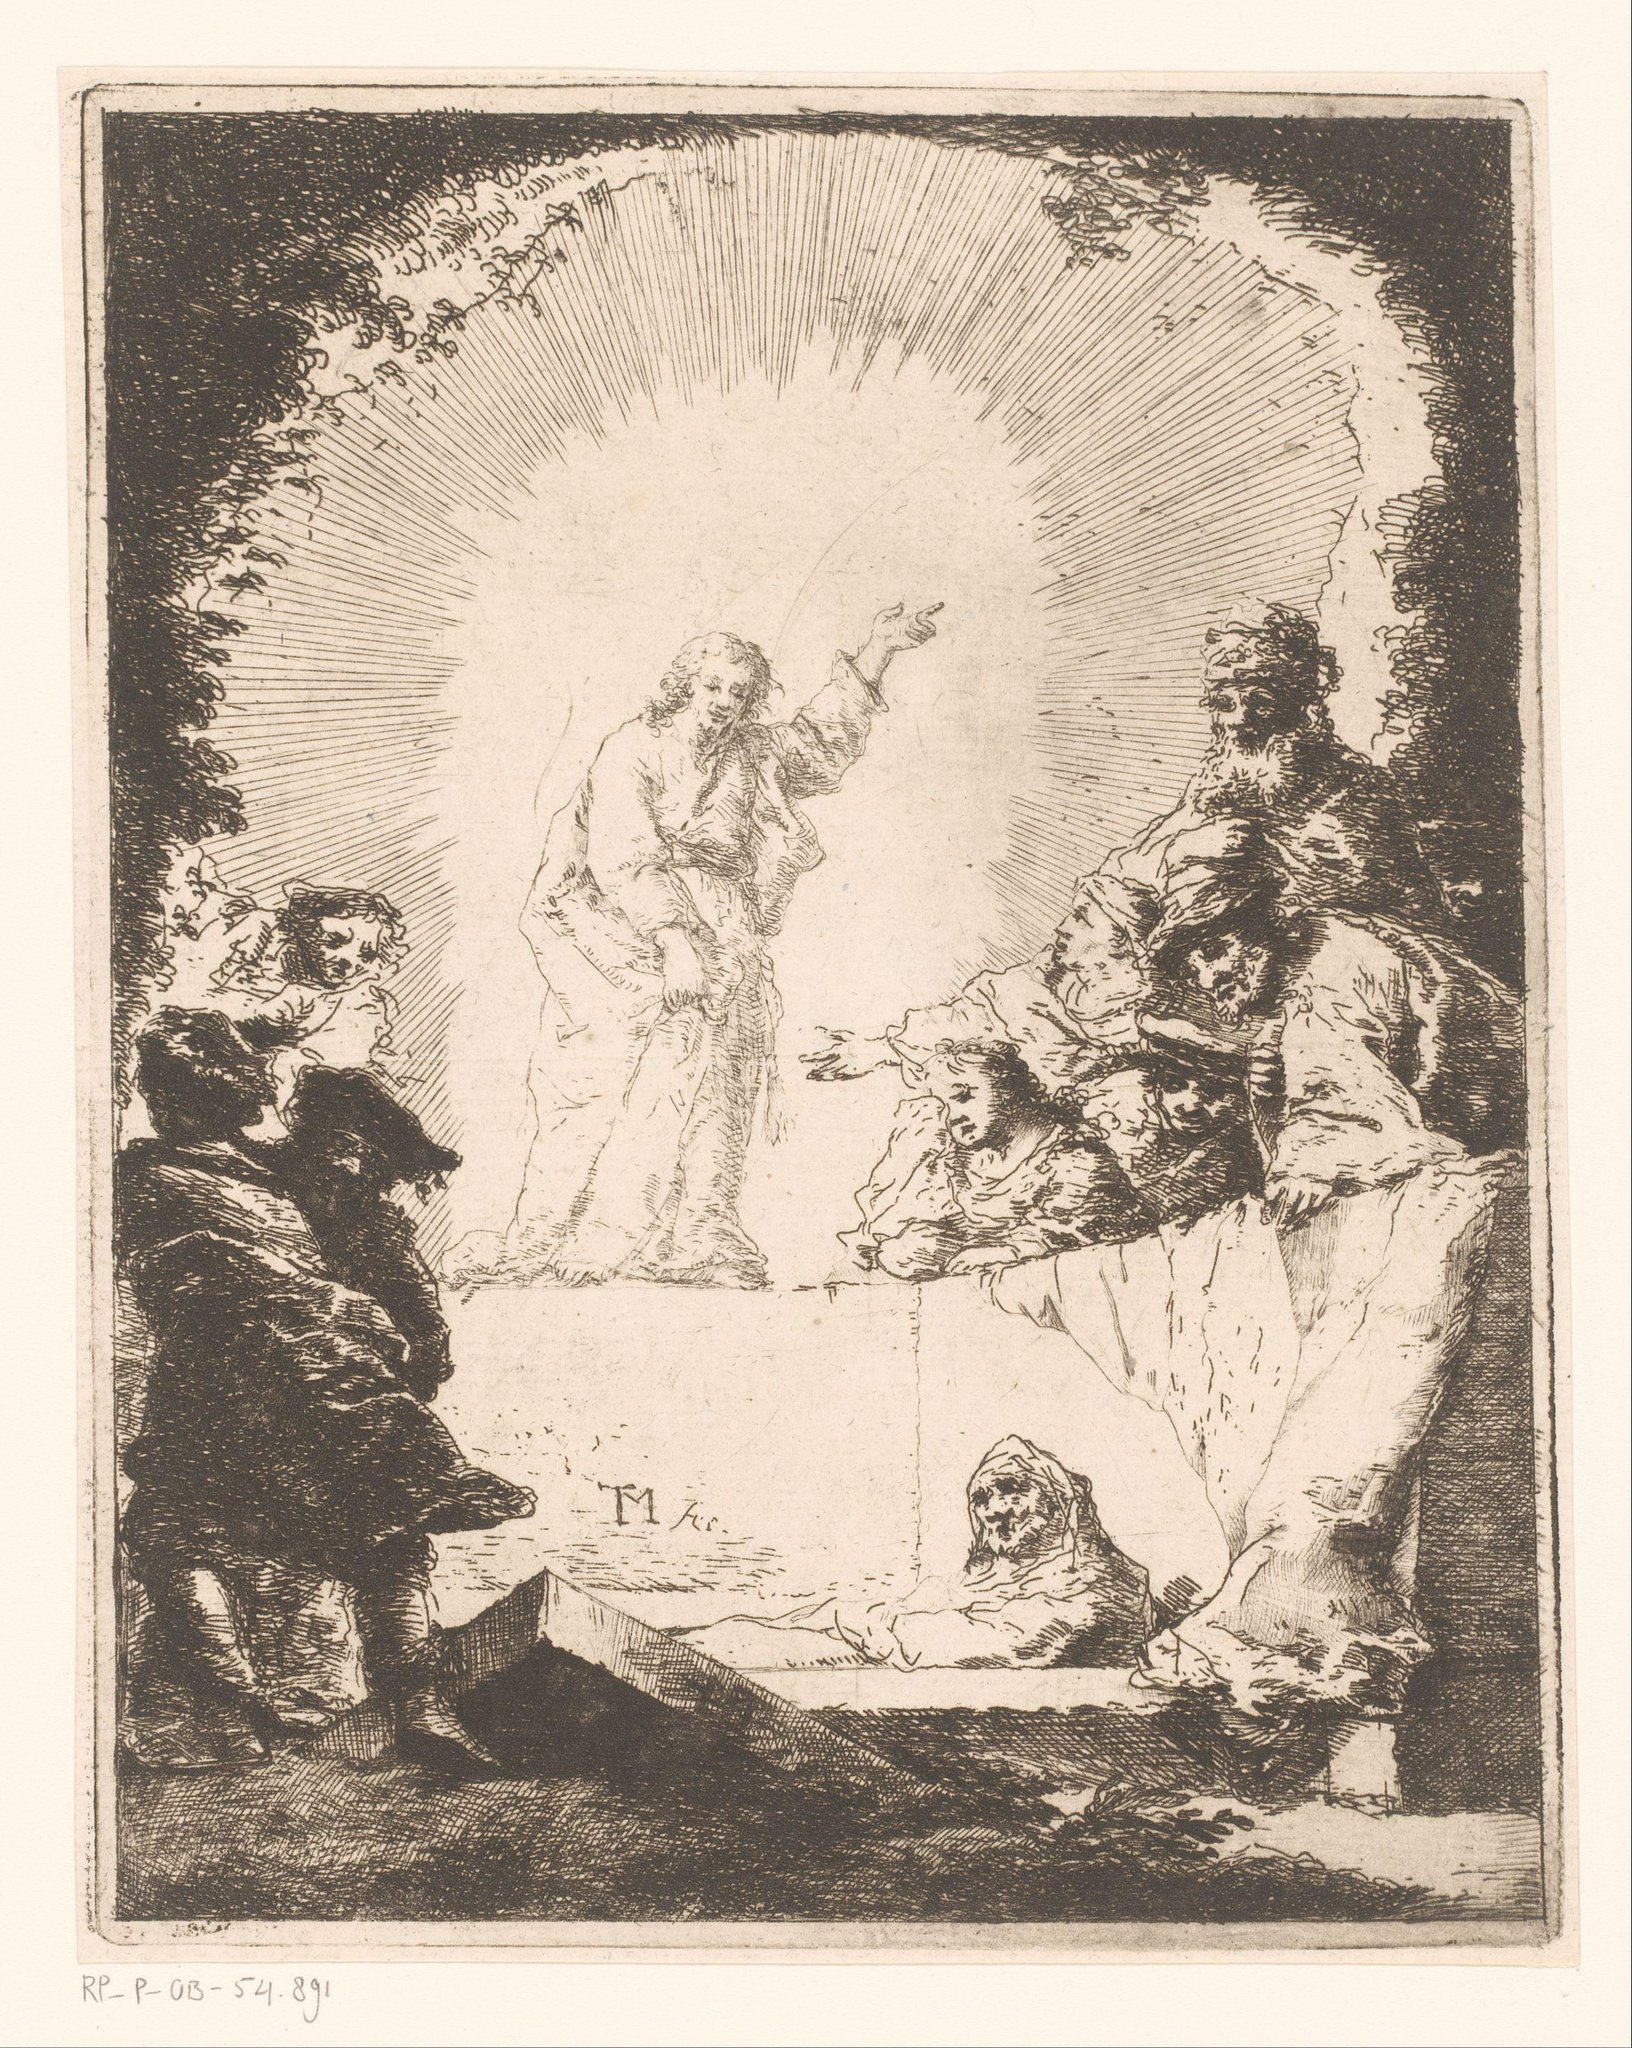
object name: print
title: Opwekking van Lazarus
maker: johann georg trautmann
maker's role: draughtsman, painter, print maker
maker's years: 1713-1769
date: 1723-1769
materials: paper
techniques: etching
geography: germany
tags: the raising of lazarus ('lazarus, come out')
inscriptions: collector's mark: Lugt 240